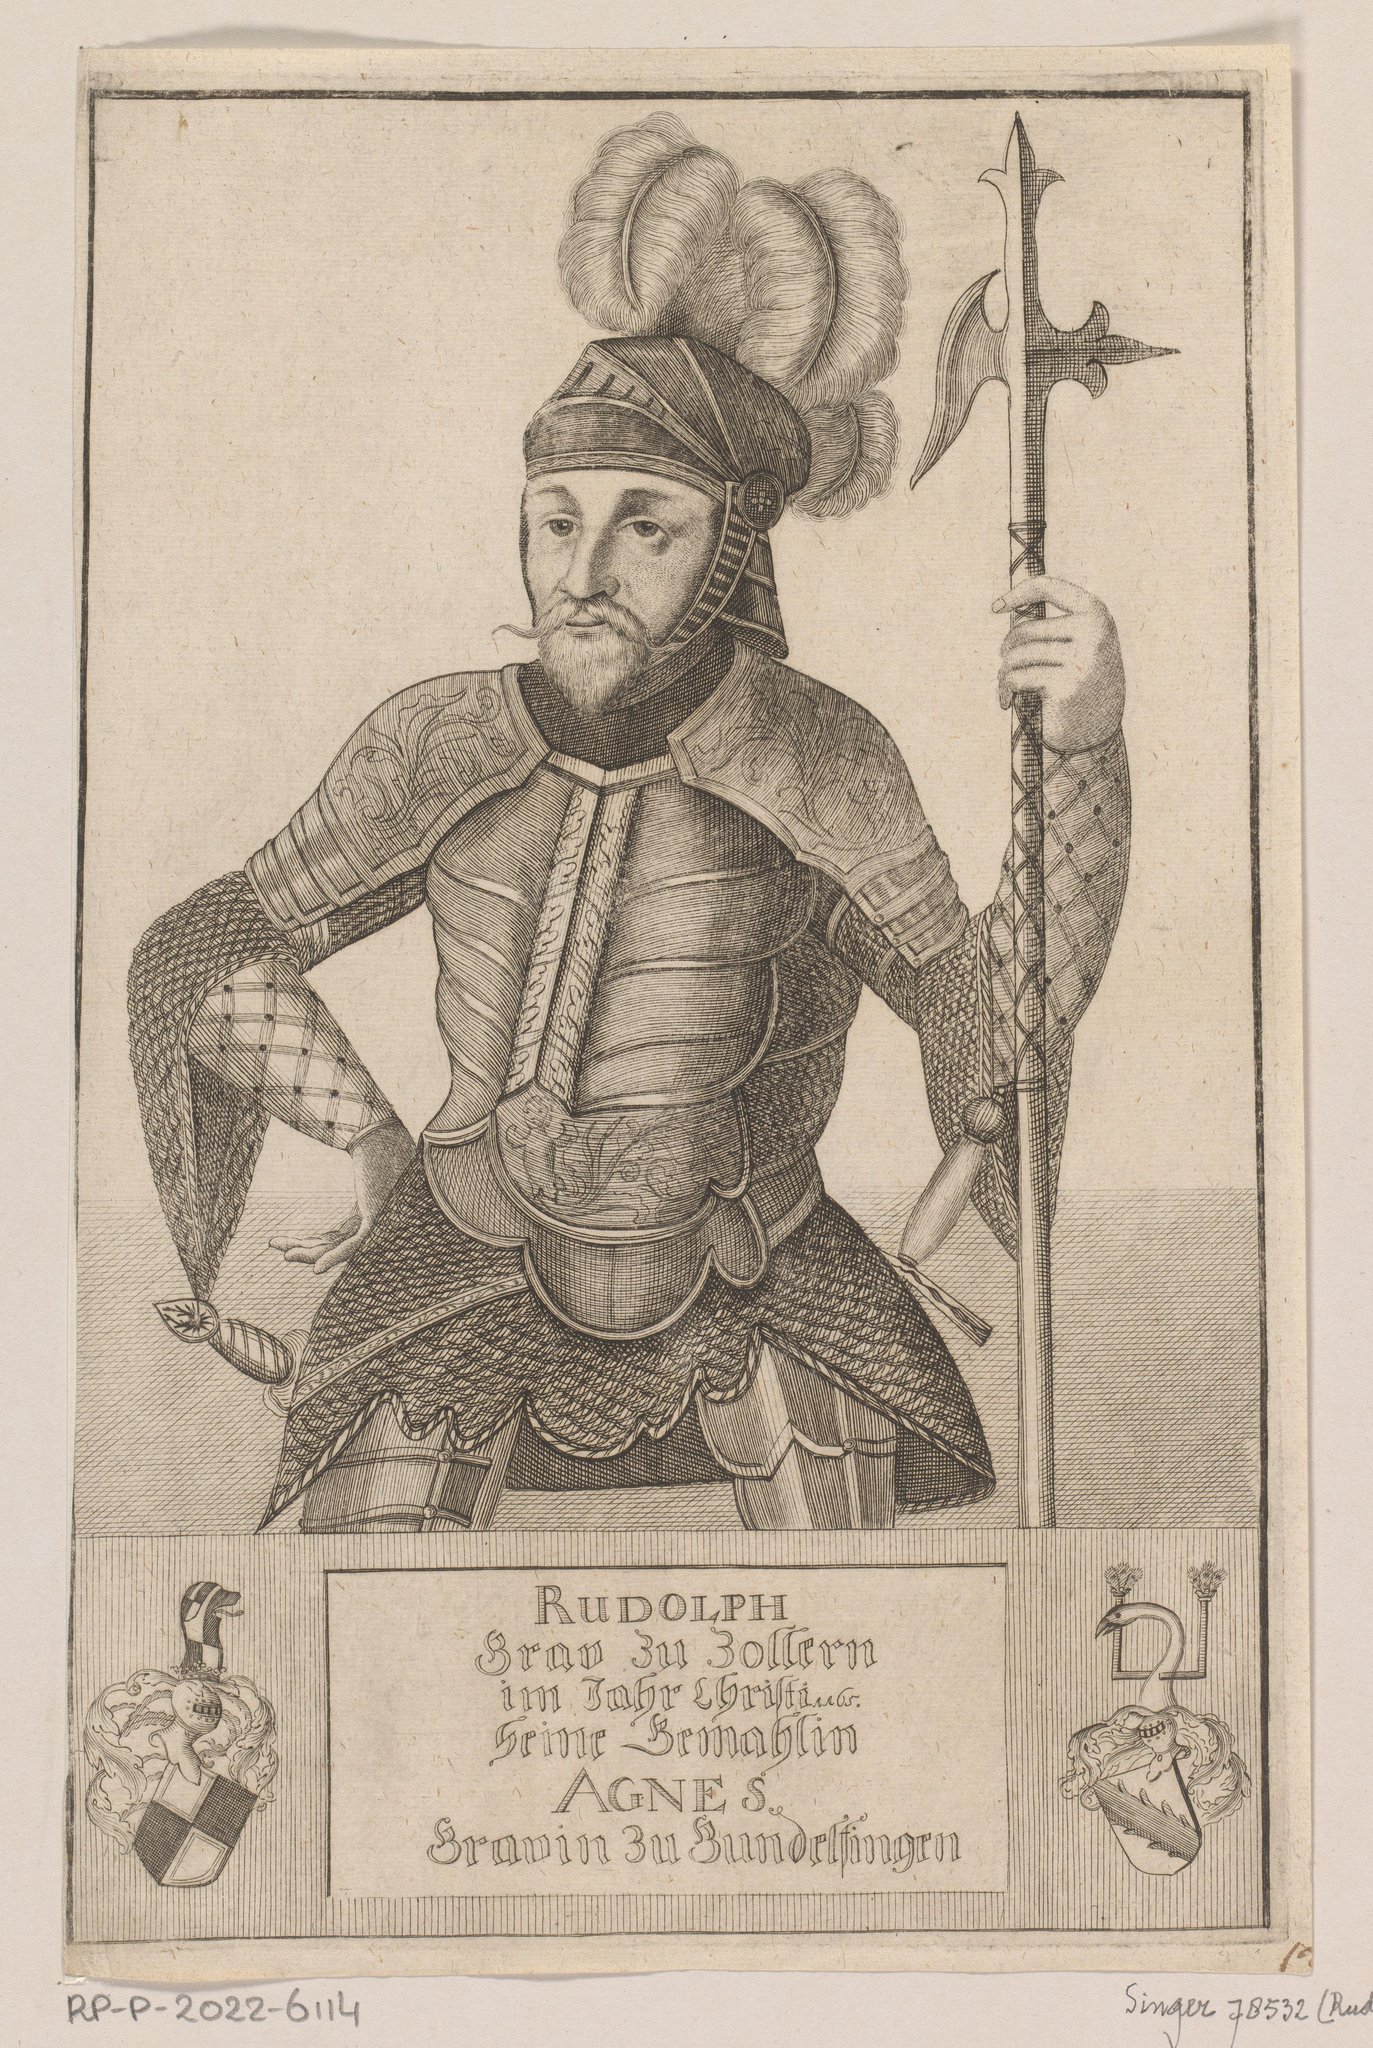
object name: print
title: Portret van Rudolph van Zollern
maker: Anonymous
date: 1714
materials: paper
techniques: engraving, etching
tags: historical persons, armorial bearing, heraldry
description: Prent waarschijnlijk uit: Pregitzer, Johann Ulrich. Deß Heiligen Römischen Reichs Teutscher Nation, und dessen Stände, Regierungs- Und Ehren-Spiegel (…). Frankfurt en Leipzig: Friedrich Rothscholtz, 1714.